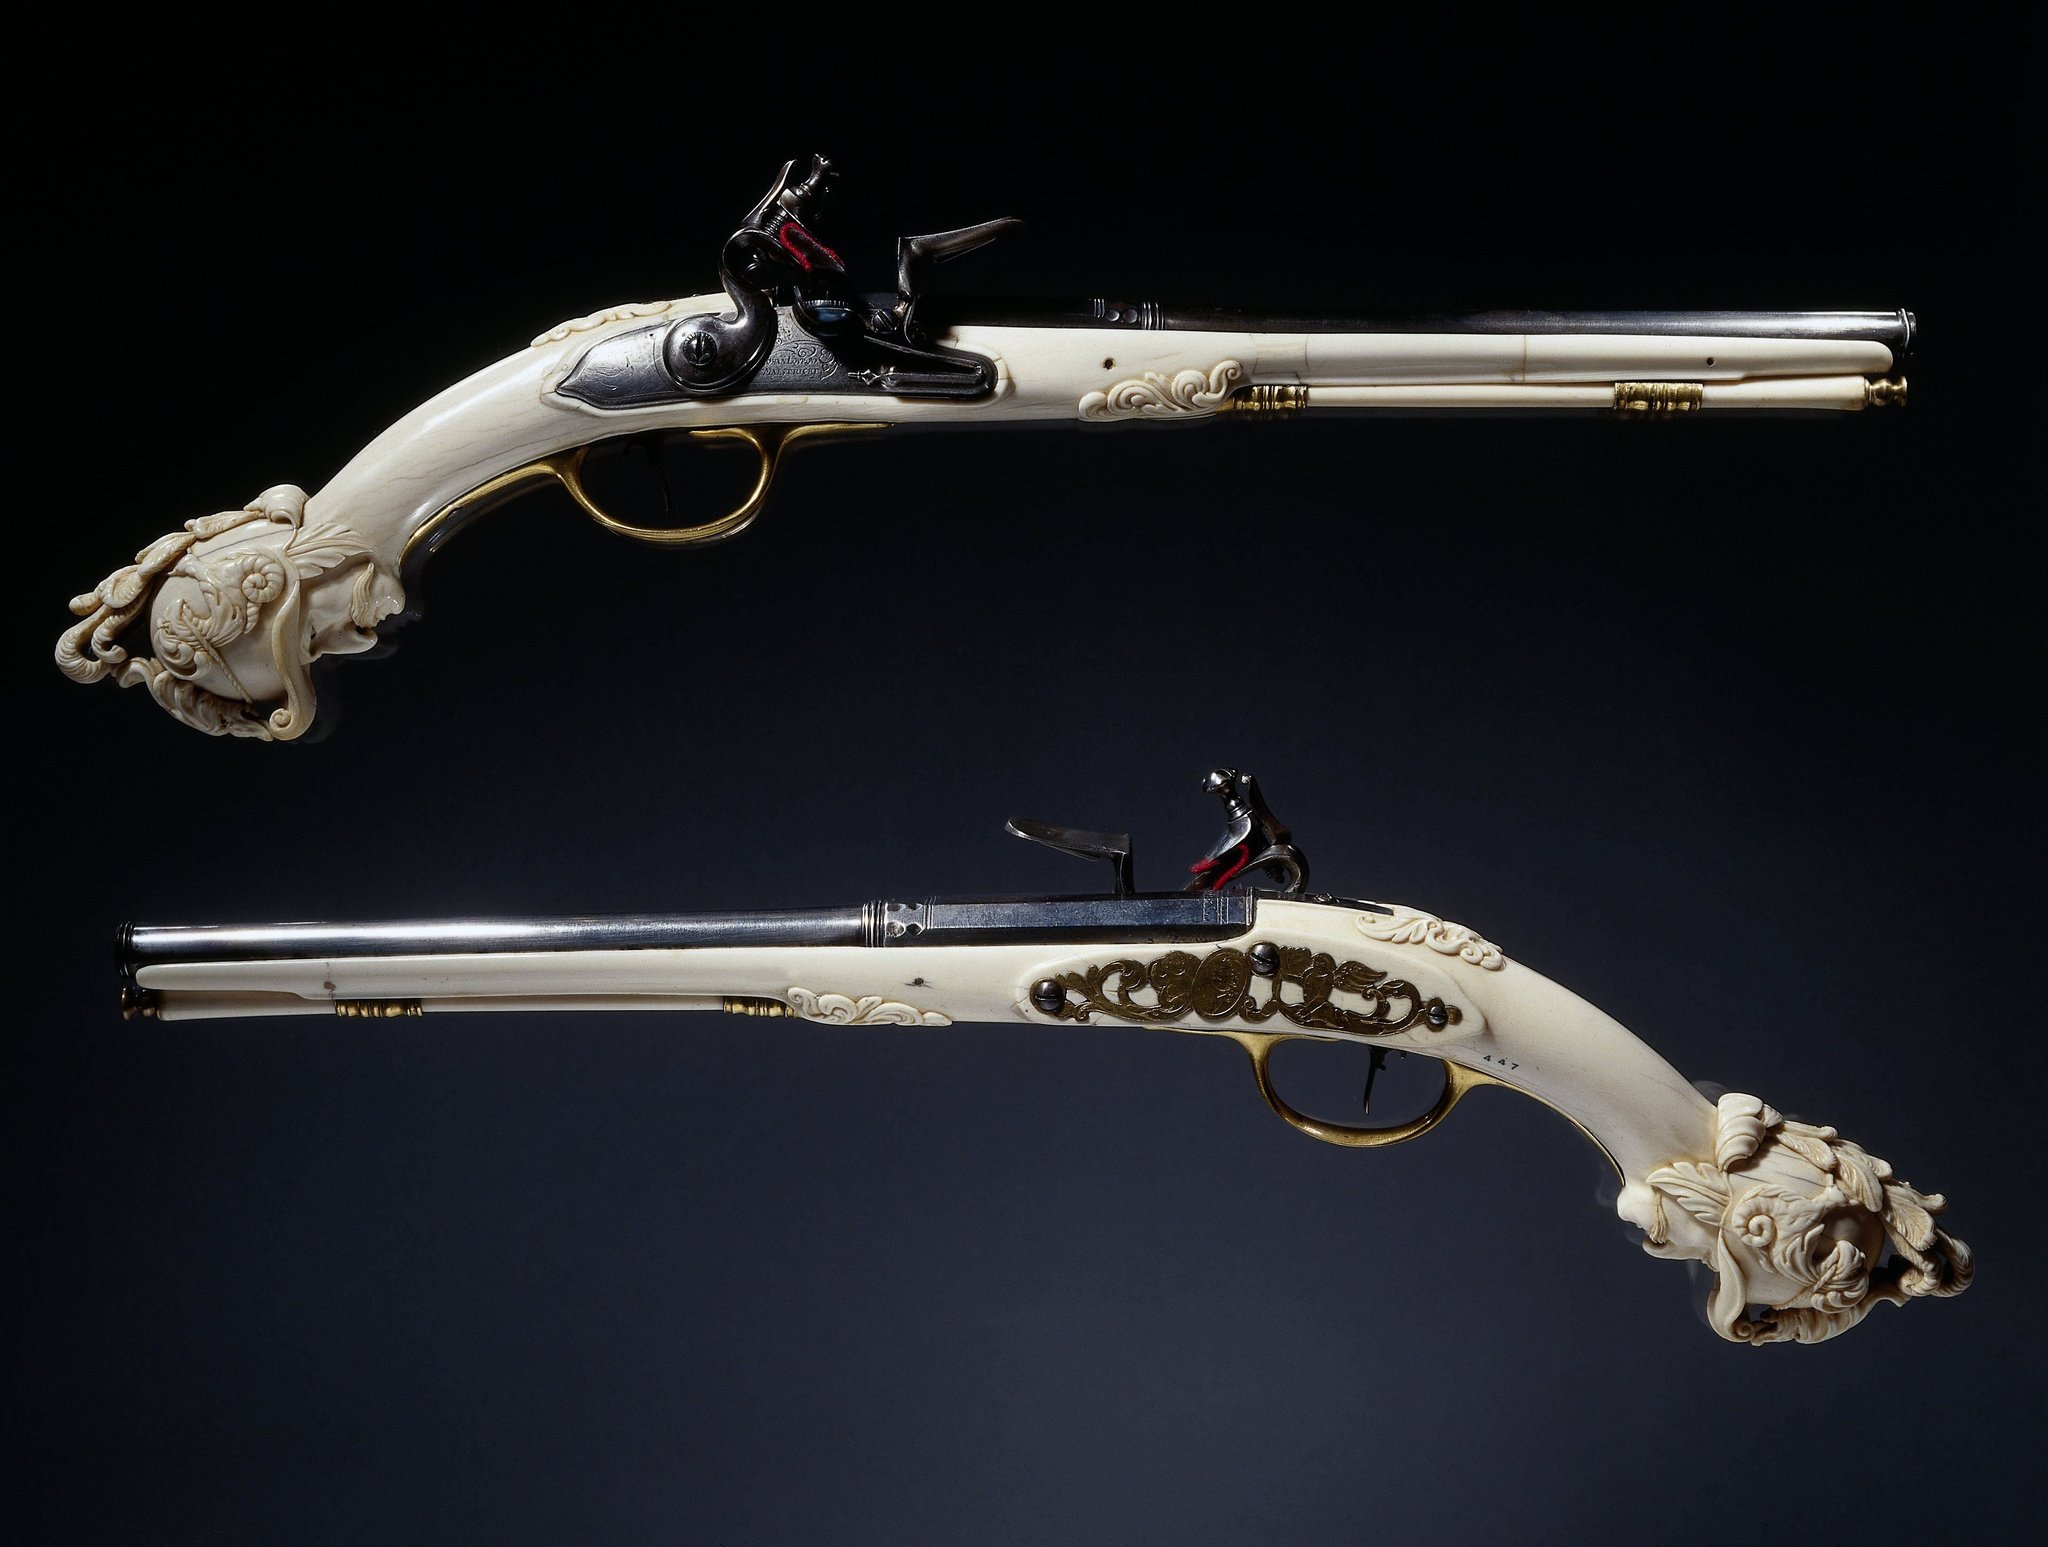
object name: flintlock pistol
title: Flintlock pistol with ivory fore-end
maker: jean louroux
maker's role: geweermaker, koopman, pistoolmaker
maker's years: -1687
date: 1665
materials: brass, iron, ivory, metal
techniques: cutting, embroidery, engraving, gilding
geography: maastricht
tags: maastricht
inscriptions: inscription: ‘IOHAN LOVROVX // MAESTIRICHT’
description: The quality of the carving on Jean Louroux’s pistols is always extremely high. An unusual feature of this pair is that each pistols has been made from a single piece of solid ivory: as a rule the fore-end of the stock (the section in which the barrel lies) and the pommel were carved separately and then joined. The ivory on the underside of the fore-end has been carved to resemble smoke curling from the powder.